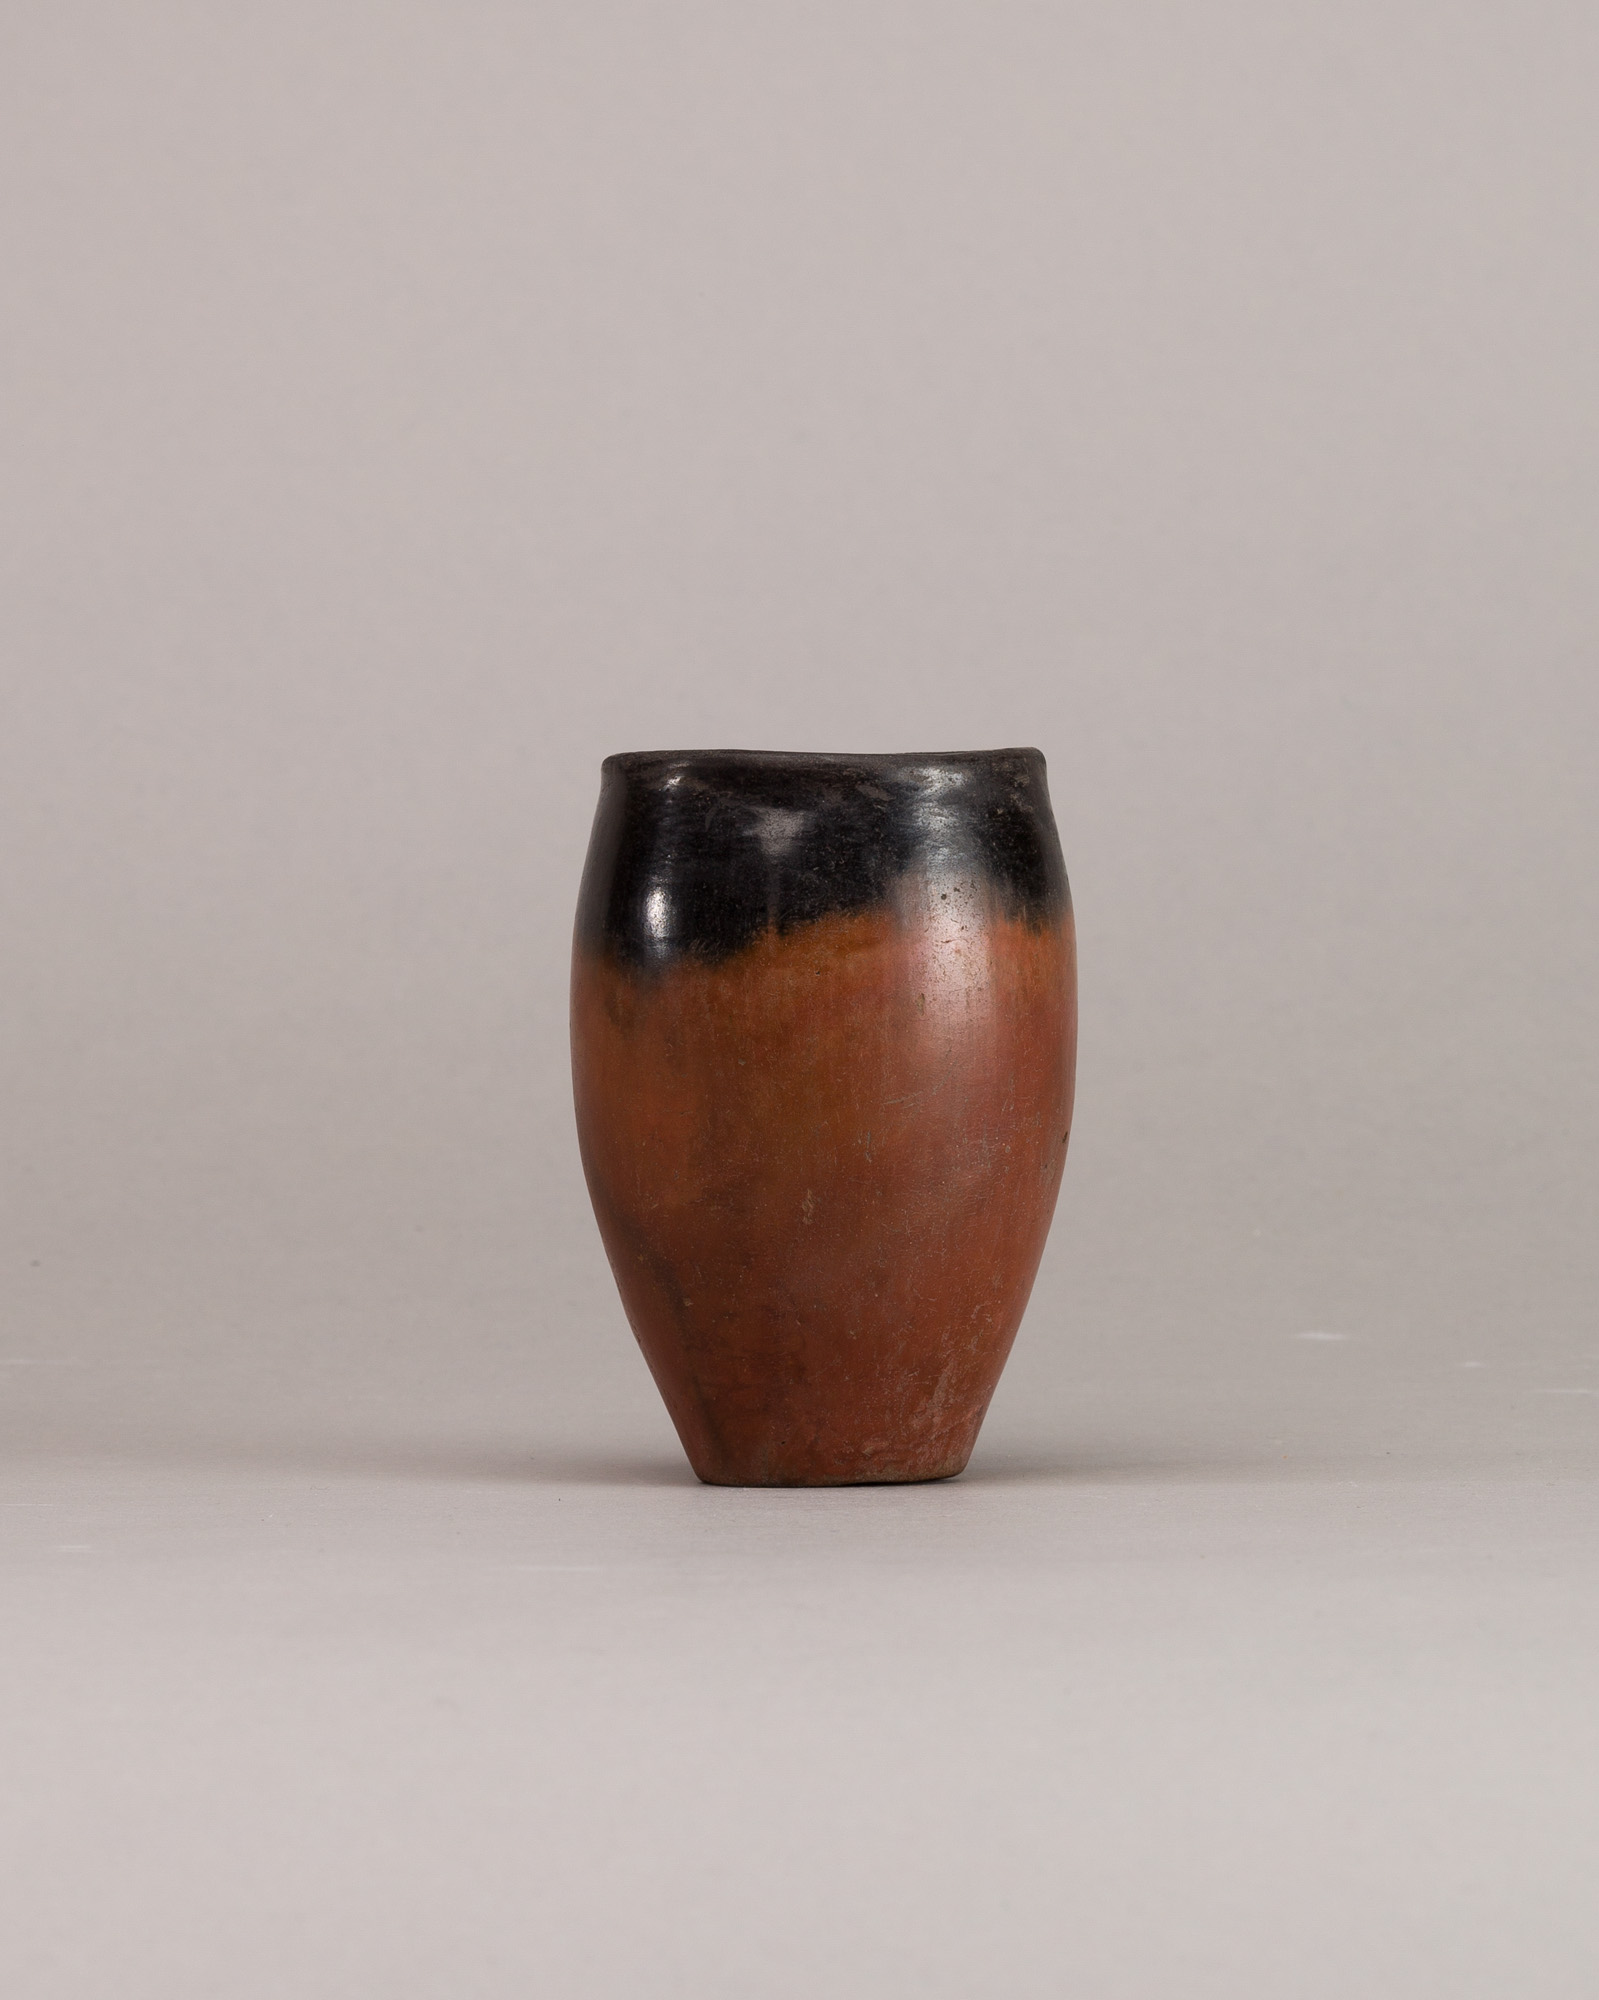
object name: jar, black topped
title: Black-topped Red Ware Jar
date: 3850-2960 BCE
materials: pottery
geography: egypt